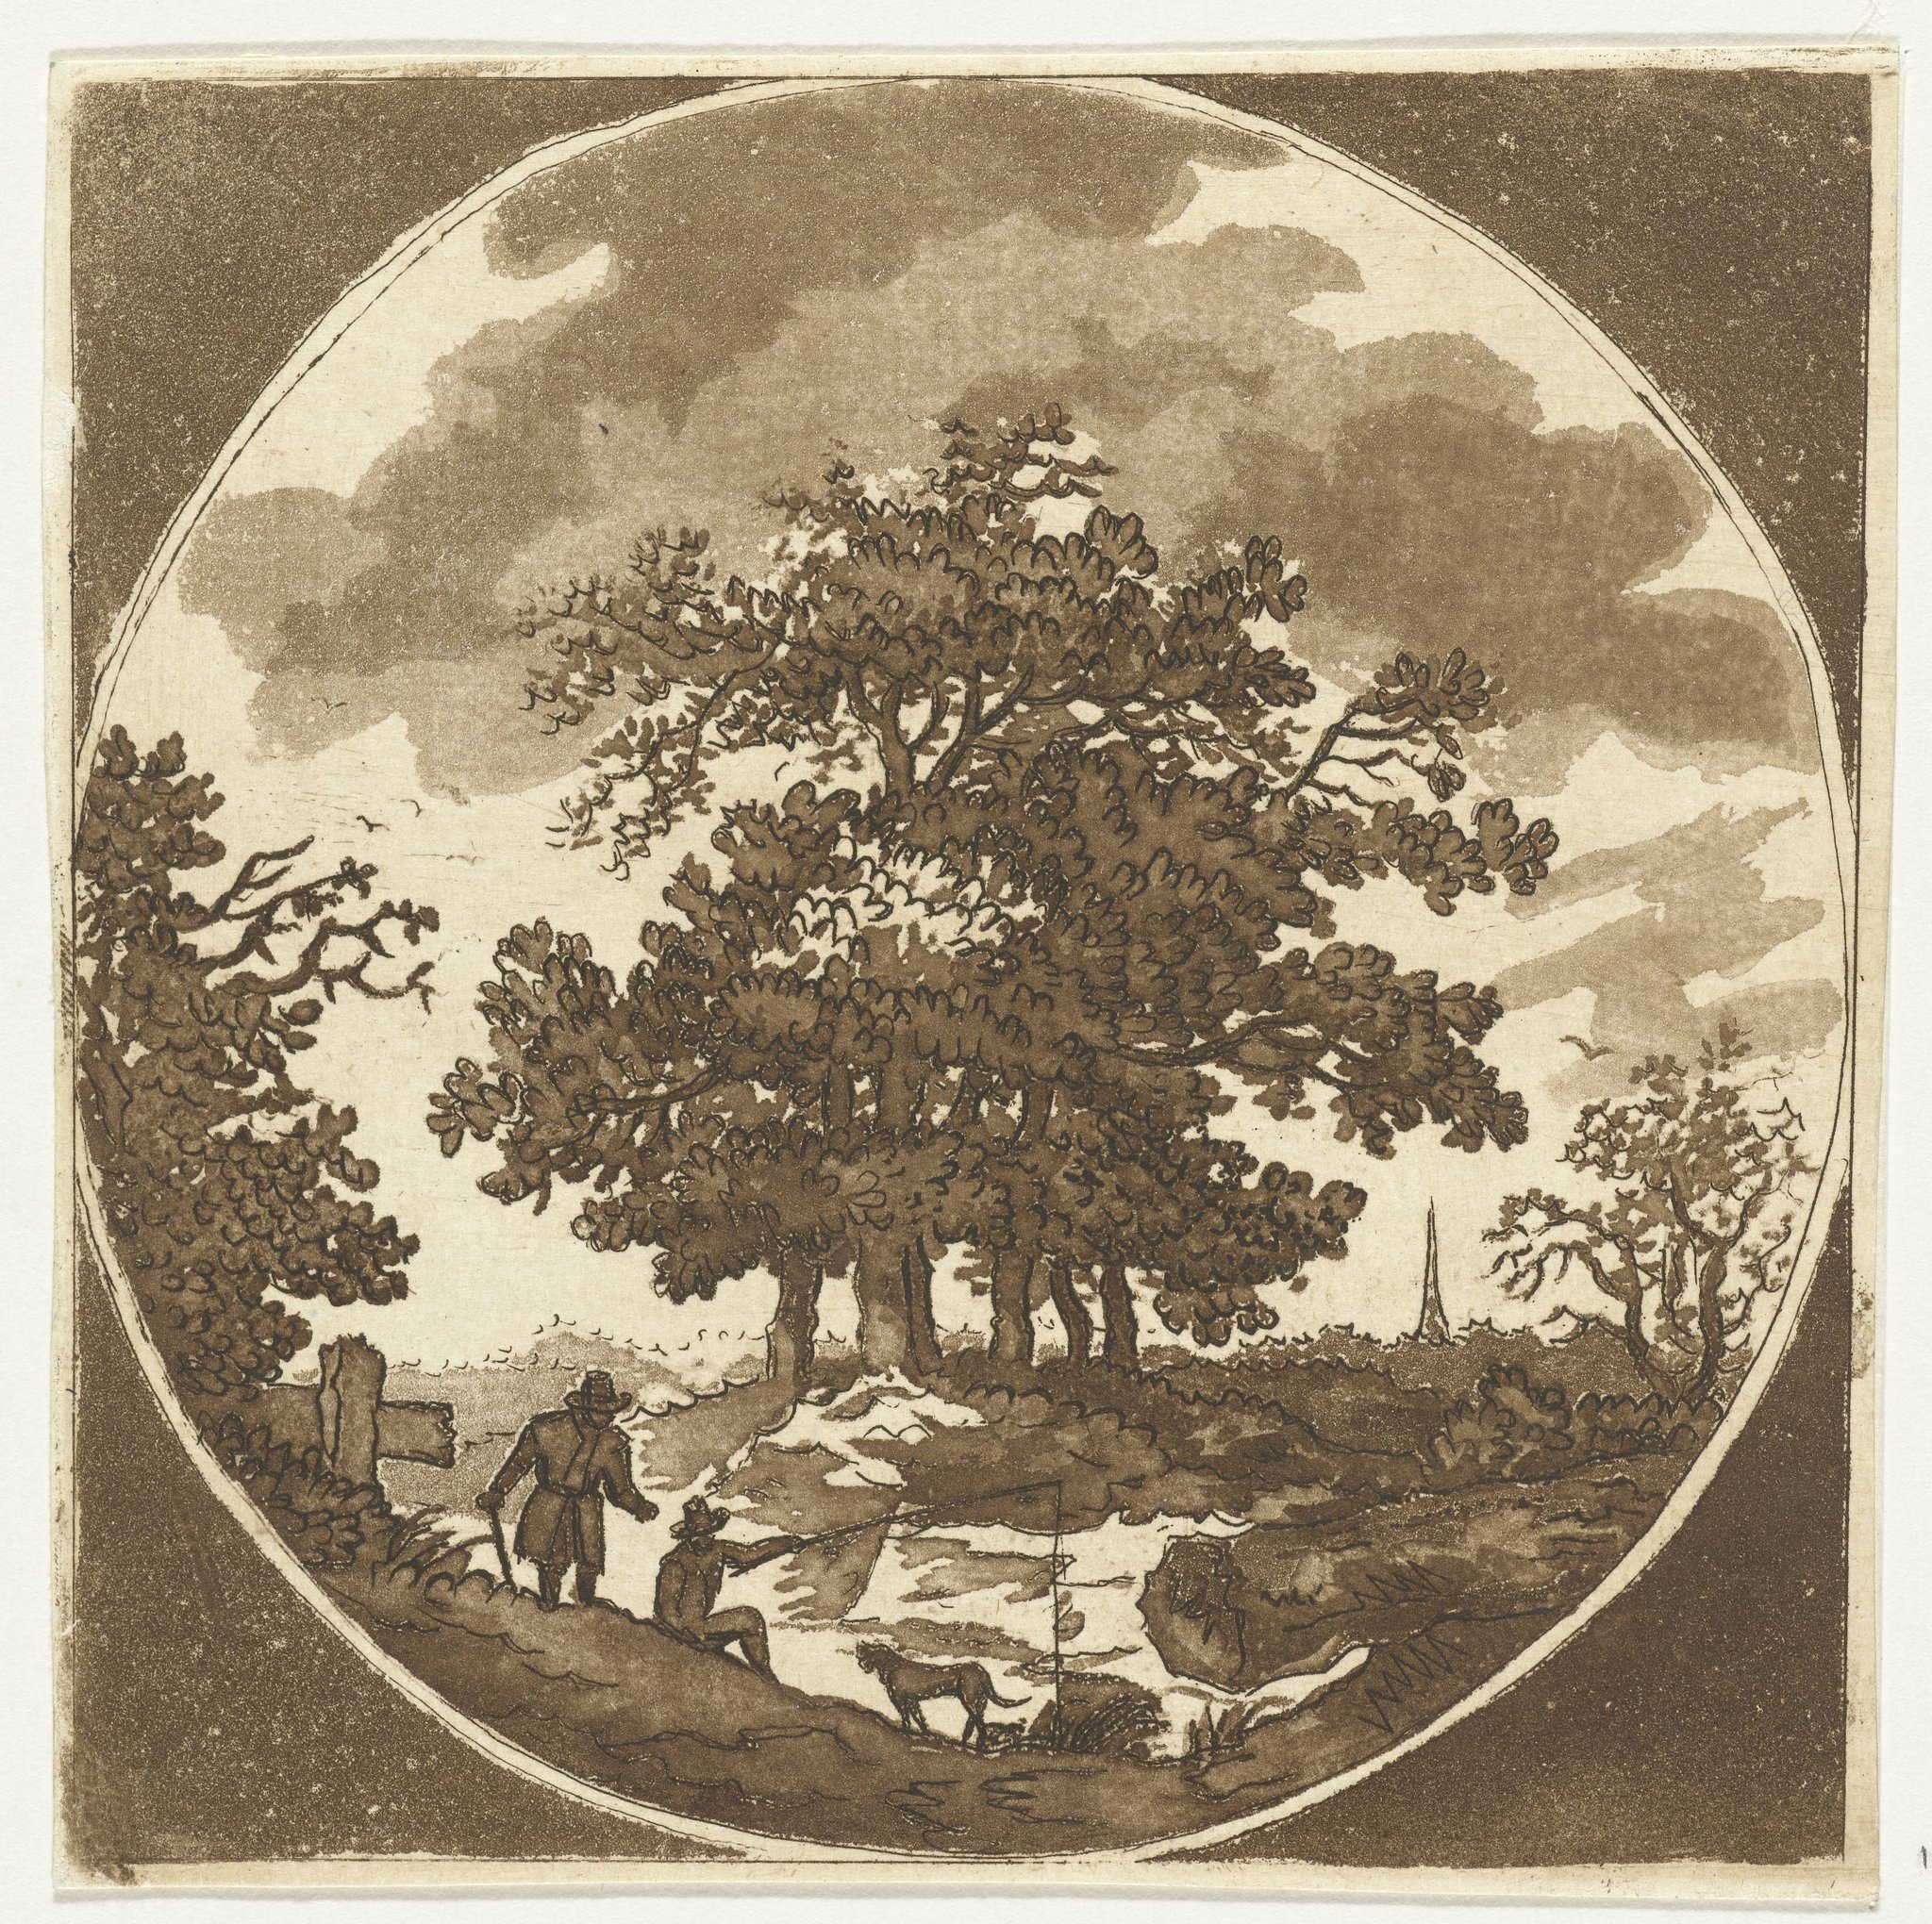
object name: print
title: Landschap met hengelaar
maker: anthonie van den bos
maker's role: draughtsman, print maker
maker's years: 1763-1838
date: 1778-1838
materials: paper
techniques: aquatint, etching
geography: netherlands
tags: landscapes with waters, waterscapes, seascapes (in the temperate zone), angling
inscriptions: collector's mark: Lugt 2228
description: Een hengelende man zit met zijn hond aan de oever van een rivier. Aan de overkant staat een groep bomen. Een wandelaar maakt een praatje met de hengelaar.